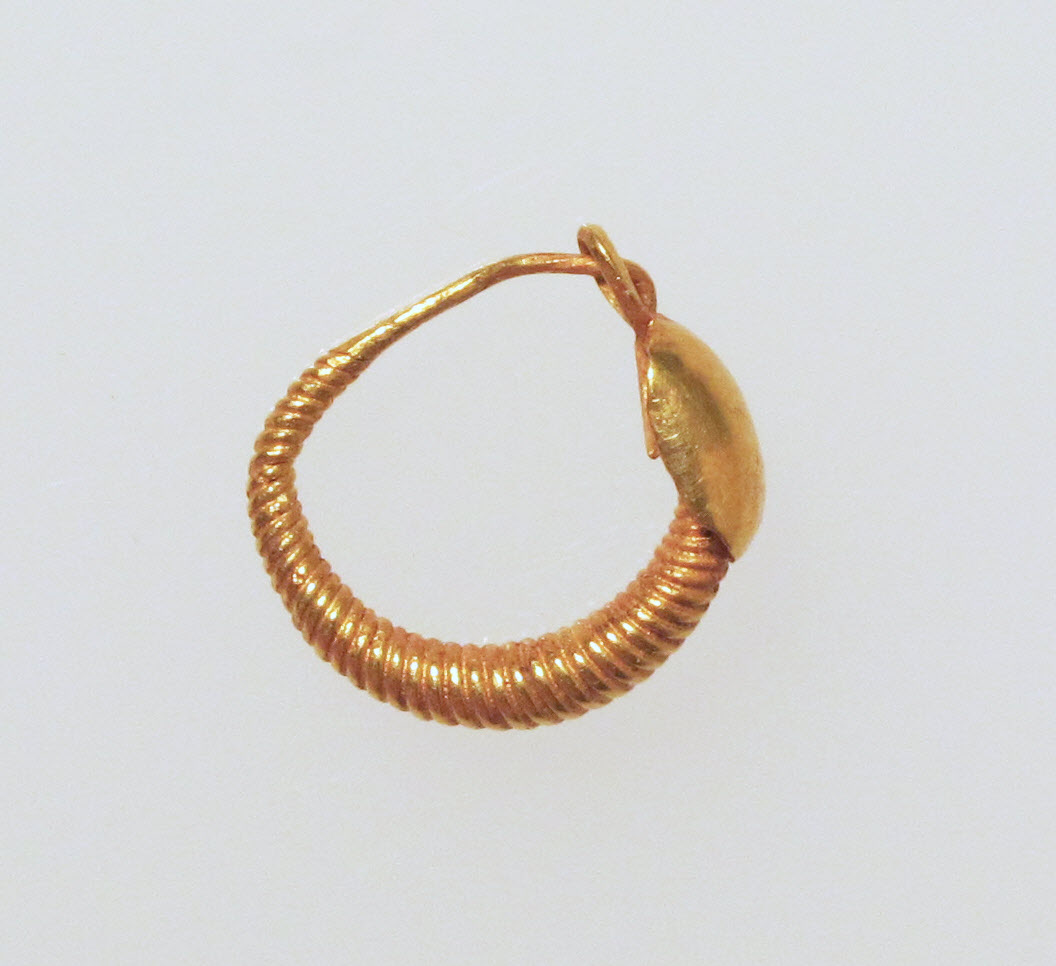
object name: earring with plain loop and disc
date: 7000 BCE-330 CE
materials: gold